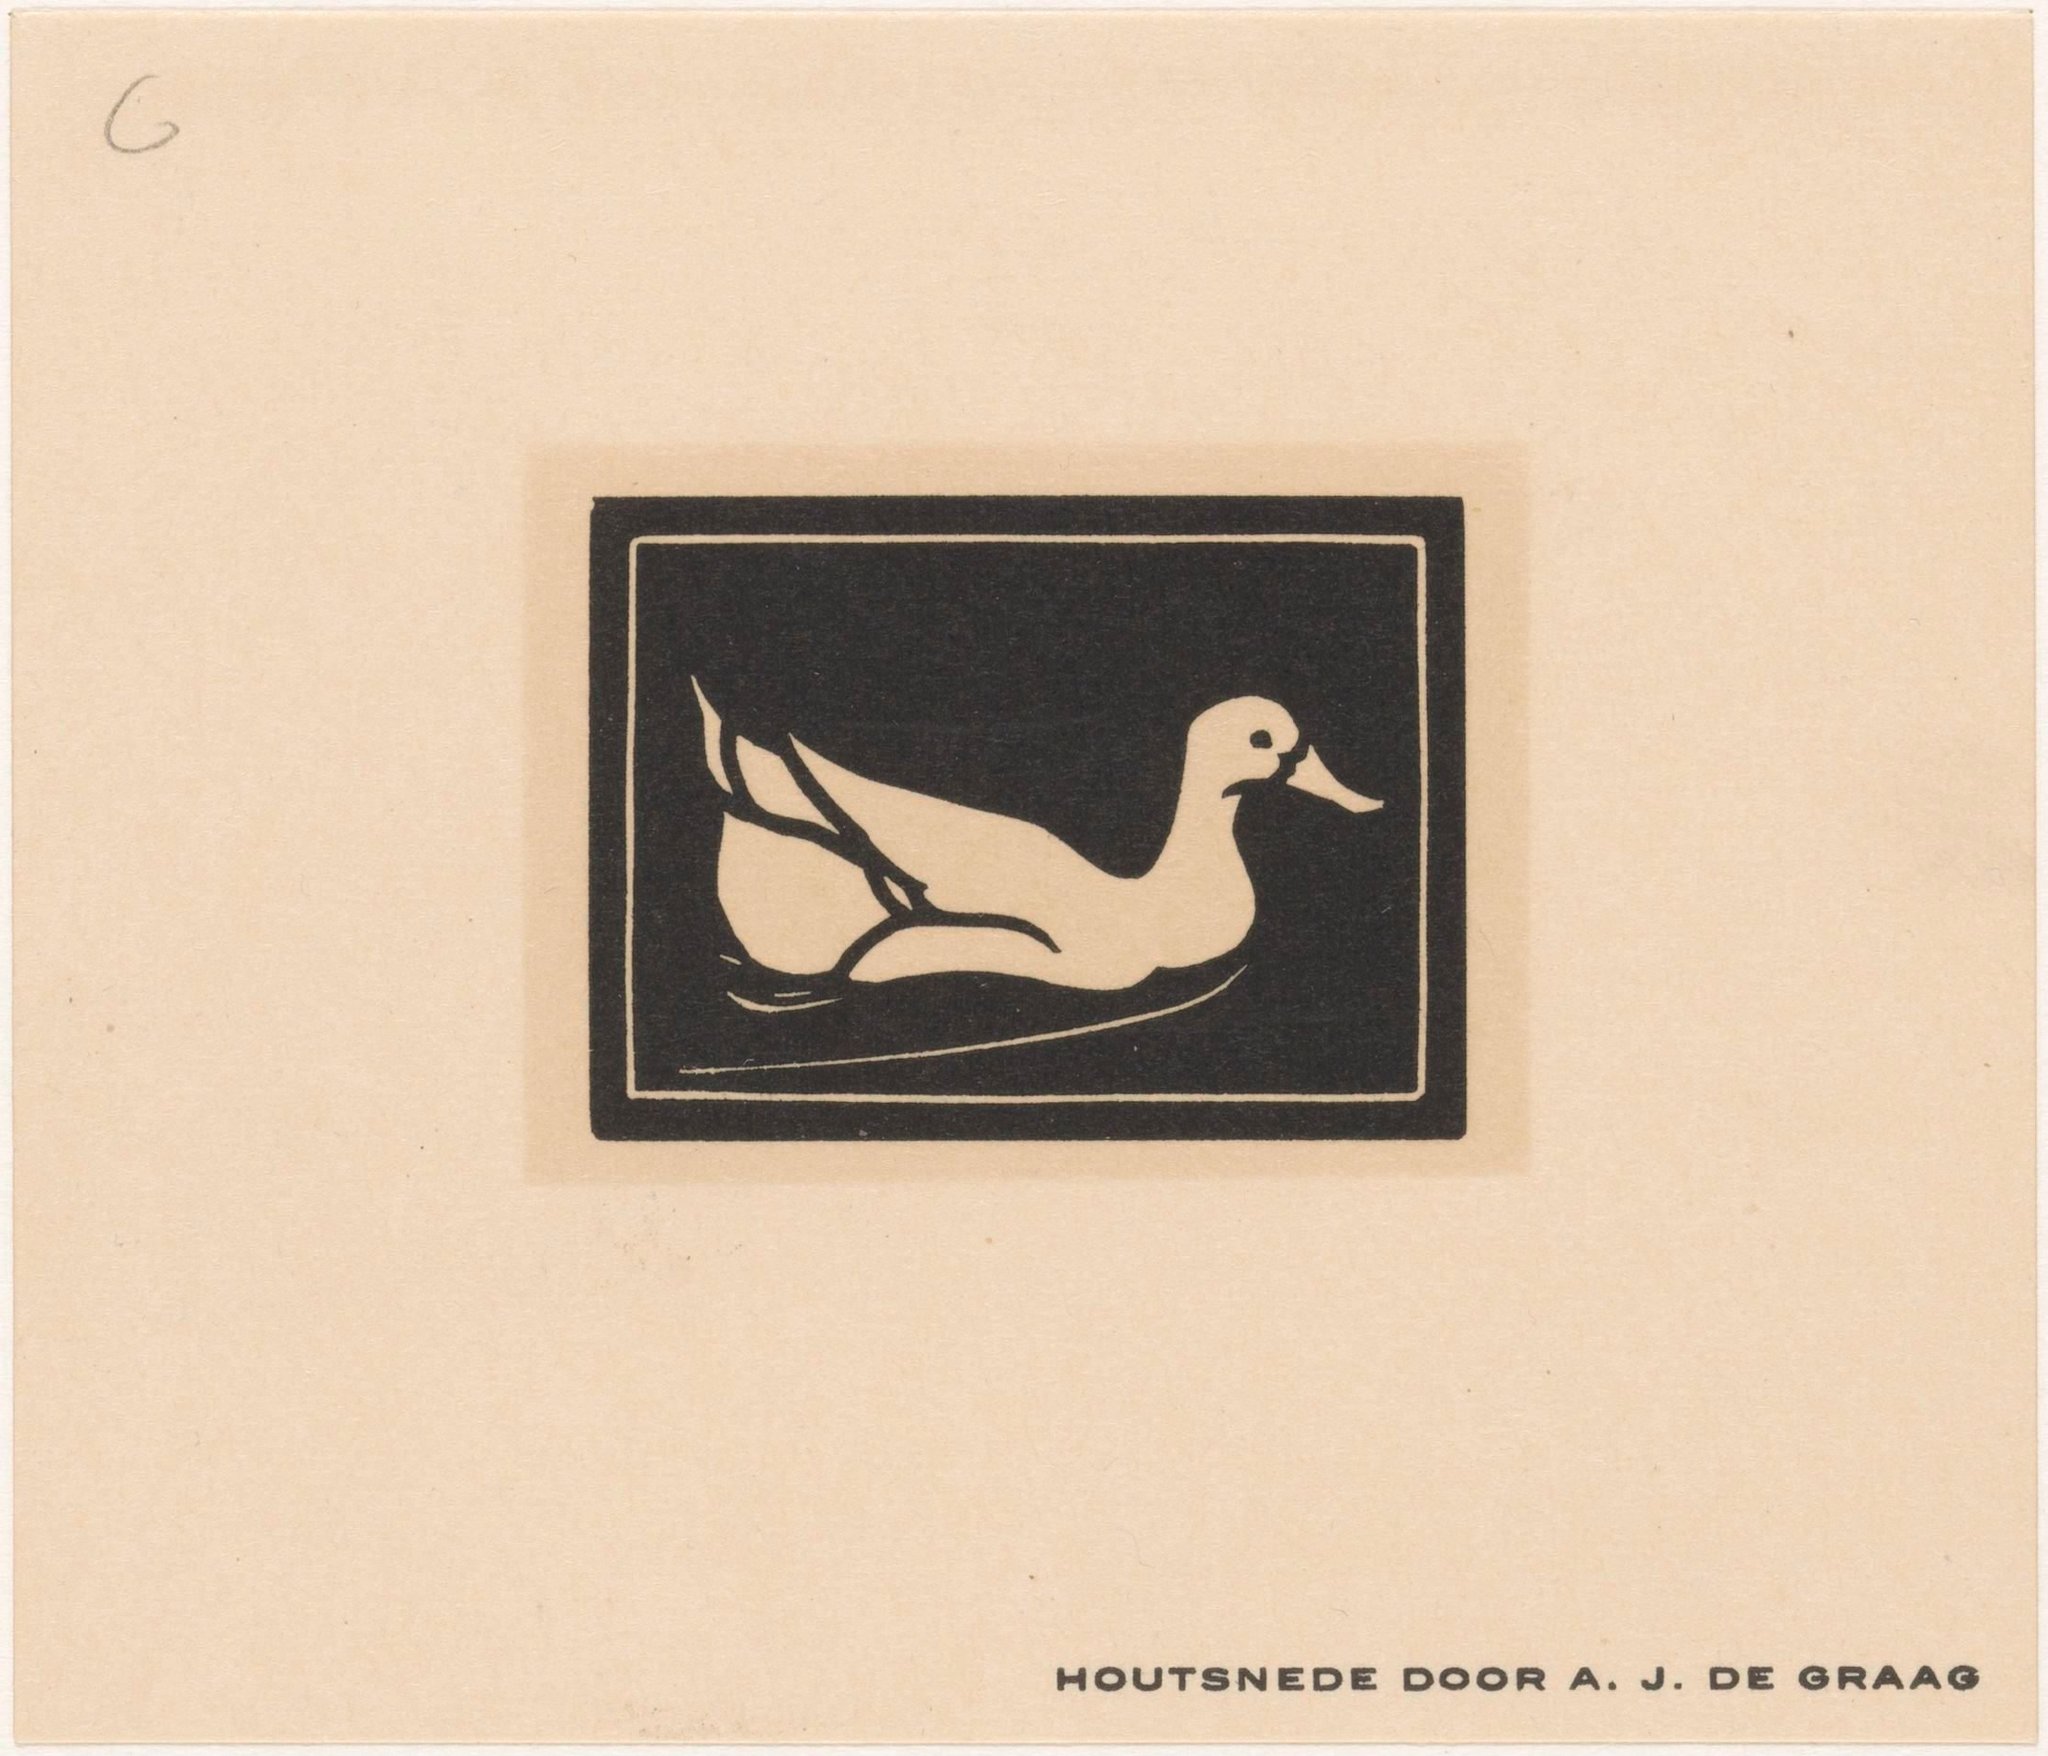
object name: print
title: Zwemmende eend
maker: julie de graag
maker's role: draughtsman, print maker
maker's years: 1877-1924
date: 1923-1924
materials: paper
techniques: woodcut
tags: water-birds: duck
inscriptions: collector's mark: Lugt 2228